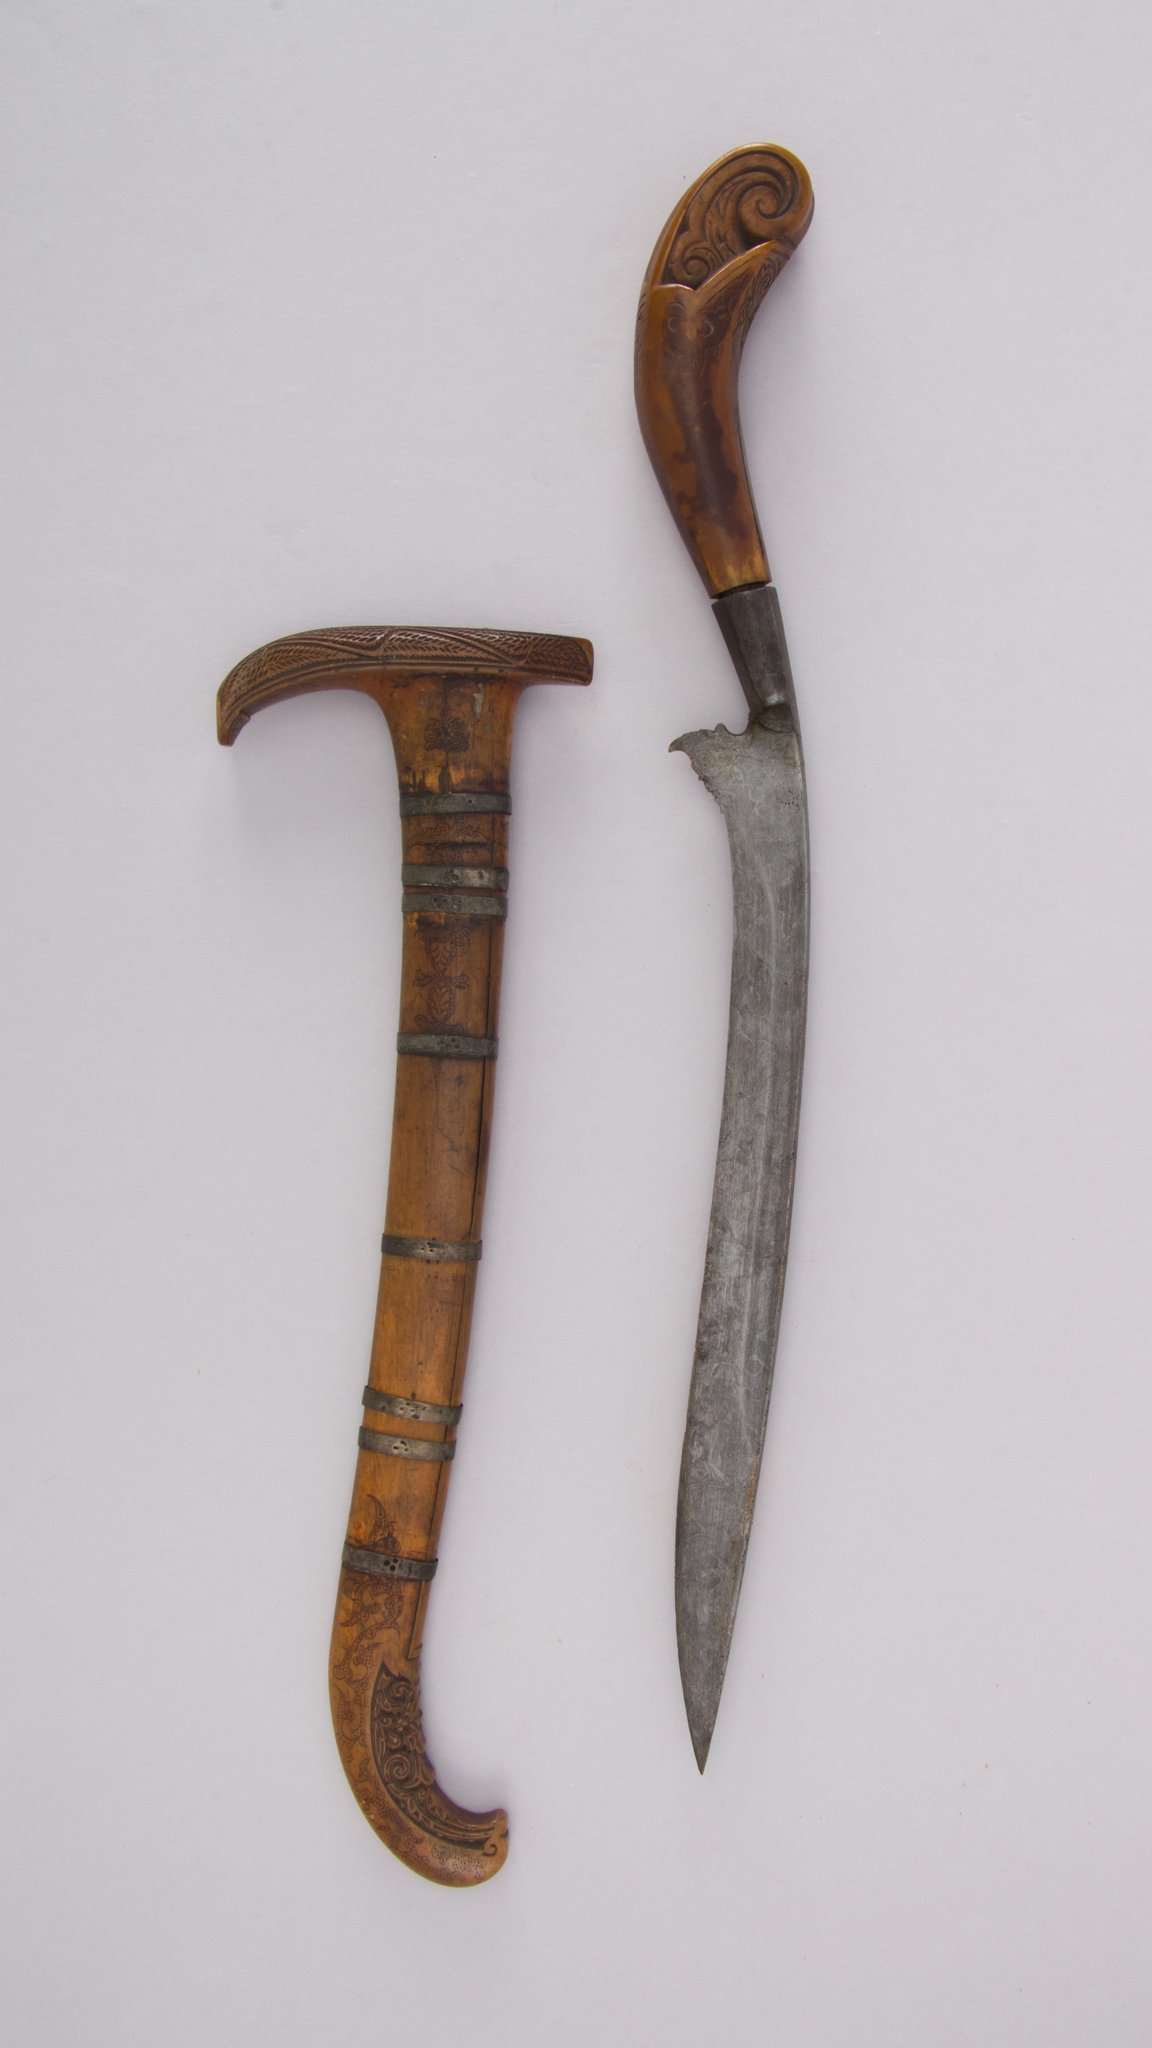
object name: dagger bade bade with sheath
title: Dagger (Bade-bade) with Sheath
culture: sumatran or acheen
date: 1501-1900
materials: bone, silver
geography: indonesia